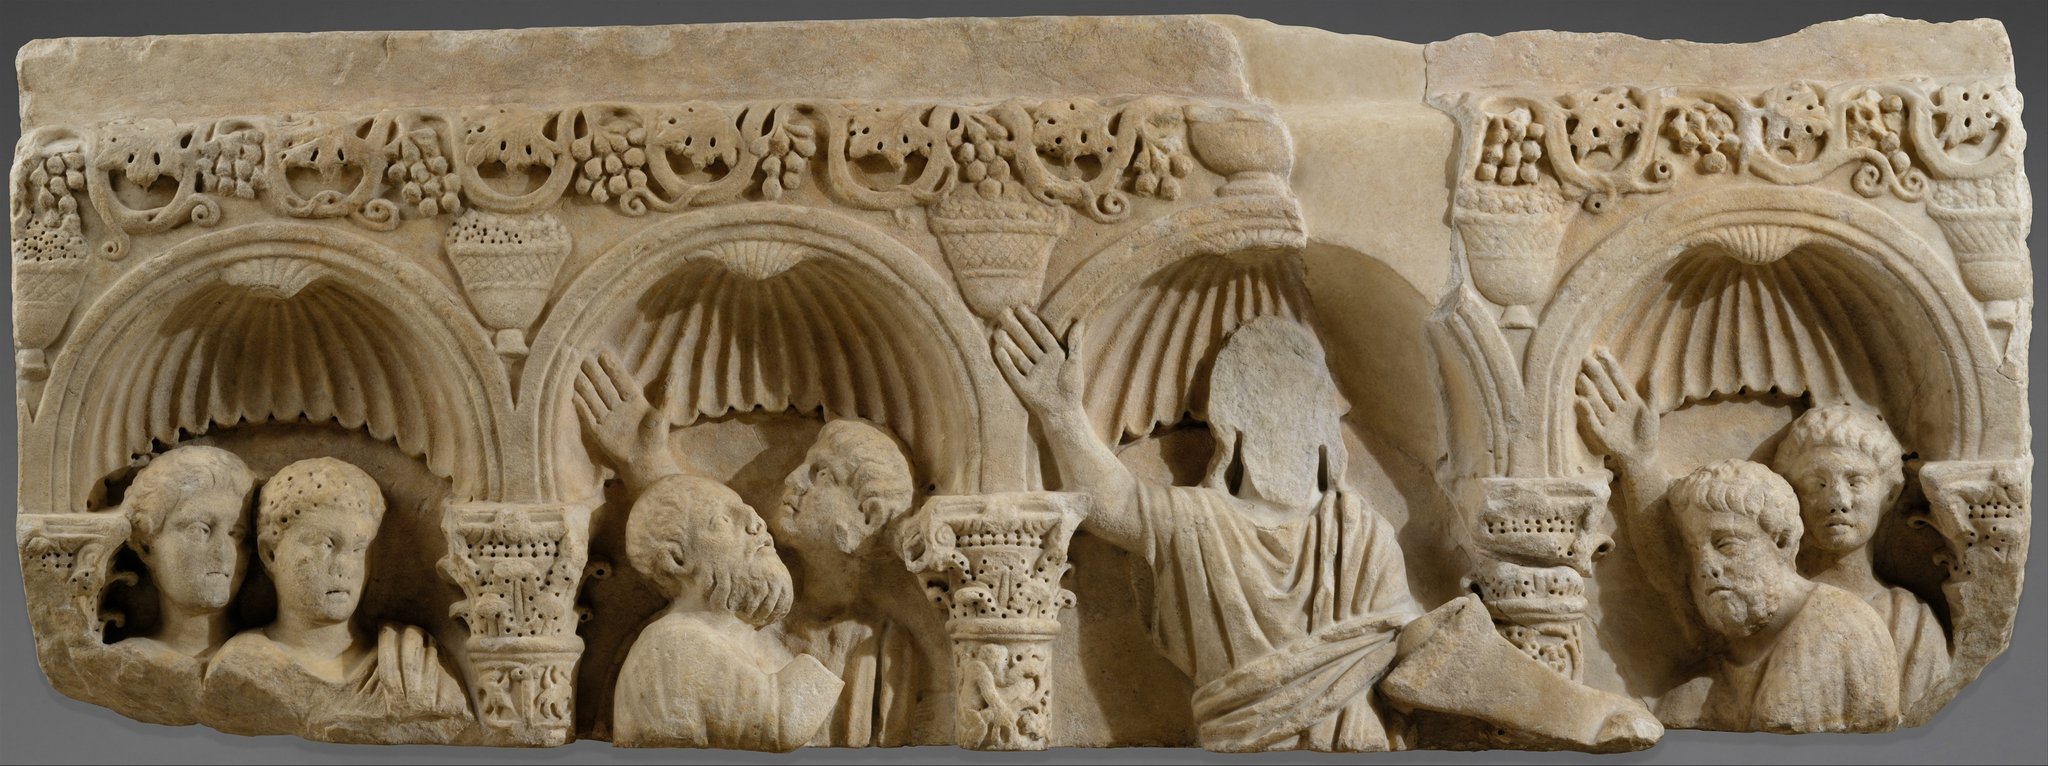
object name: sarcophagus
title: Fragment of a Marble Tomb Relief with Christ Giving the Law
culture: byzantine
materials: marble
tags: christ